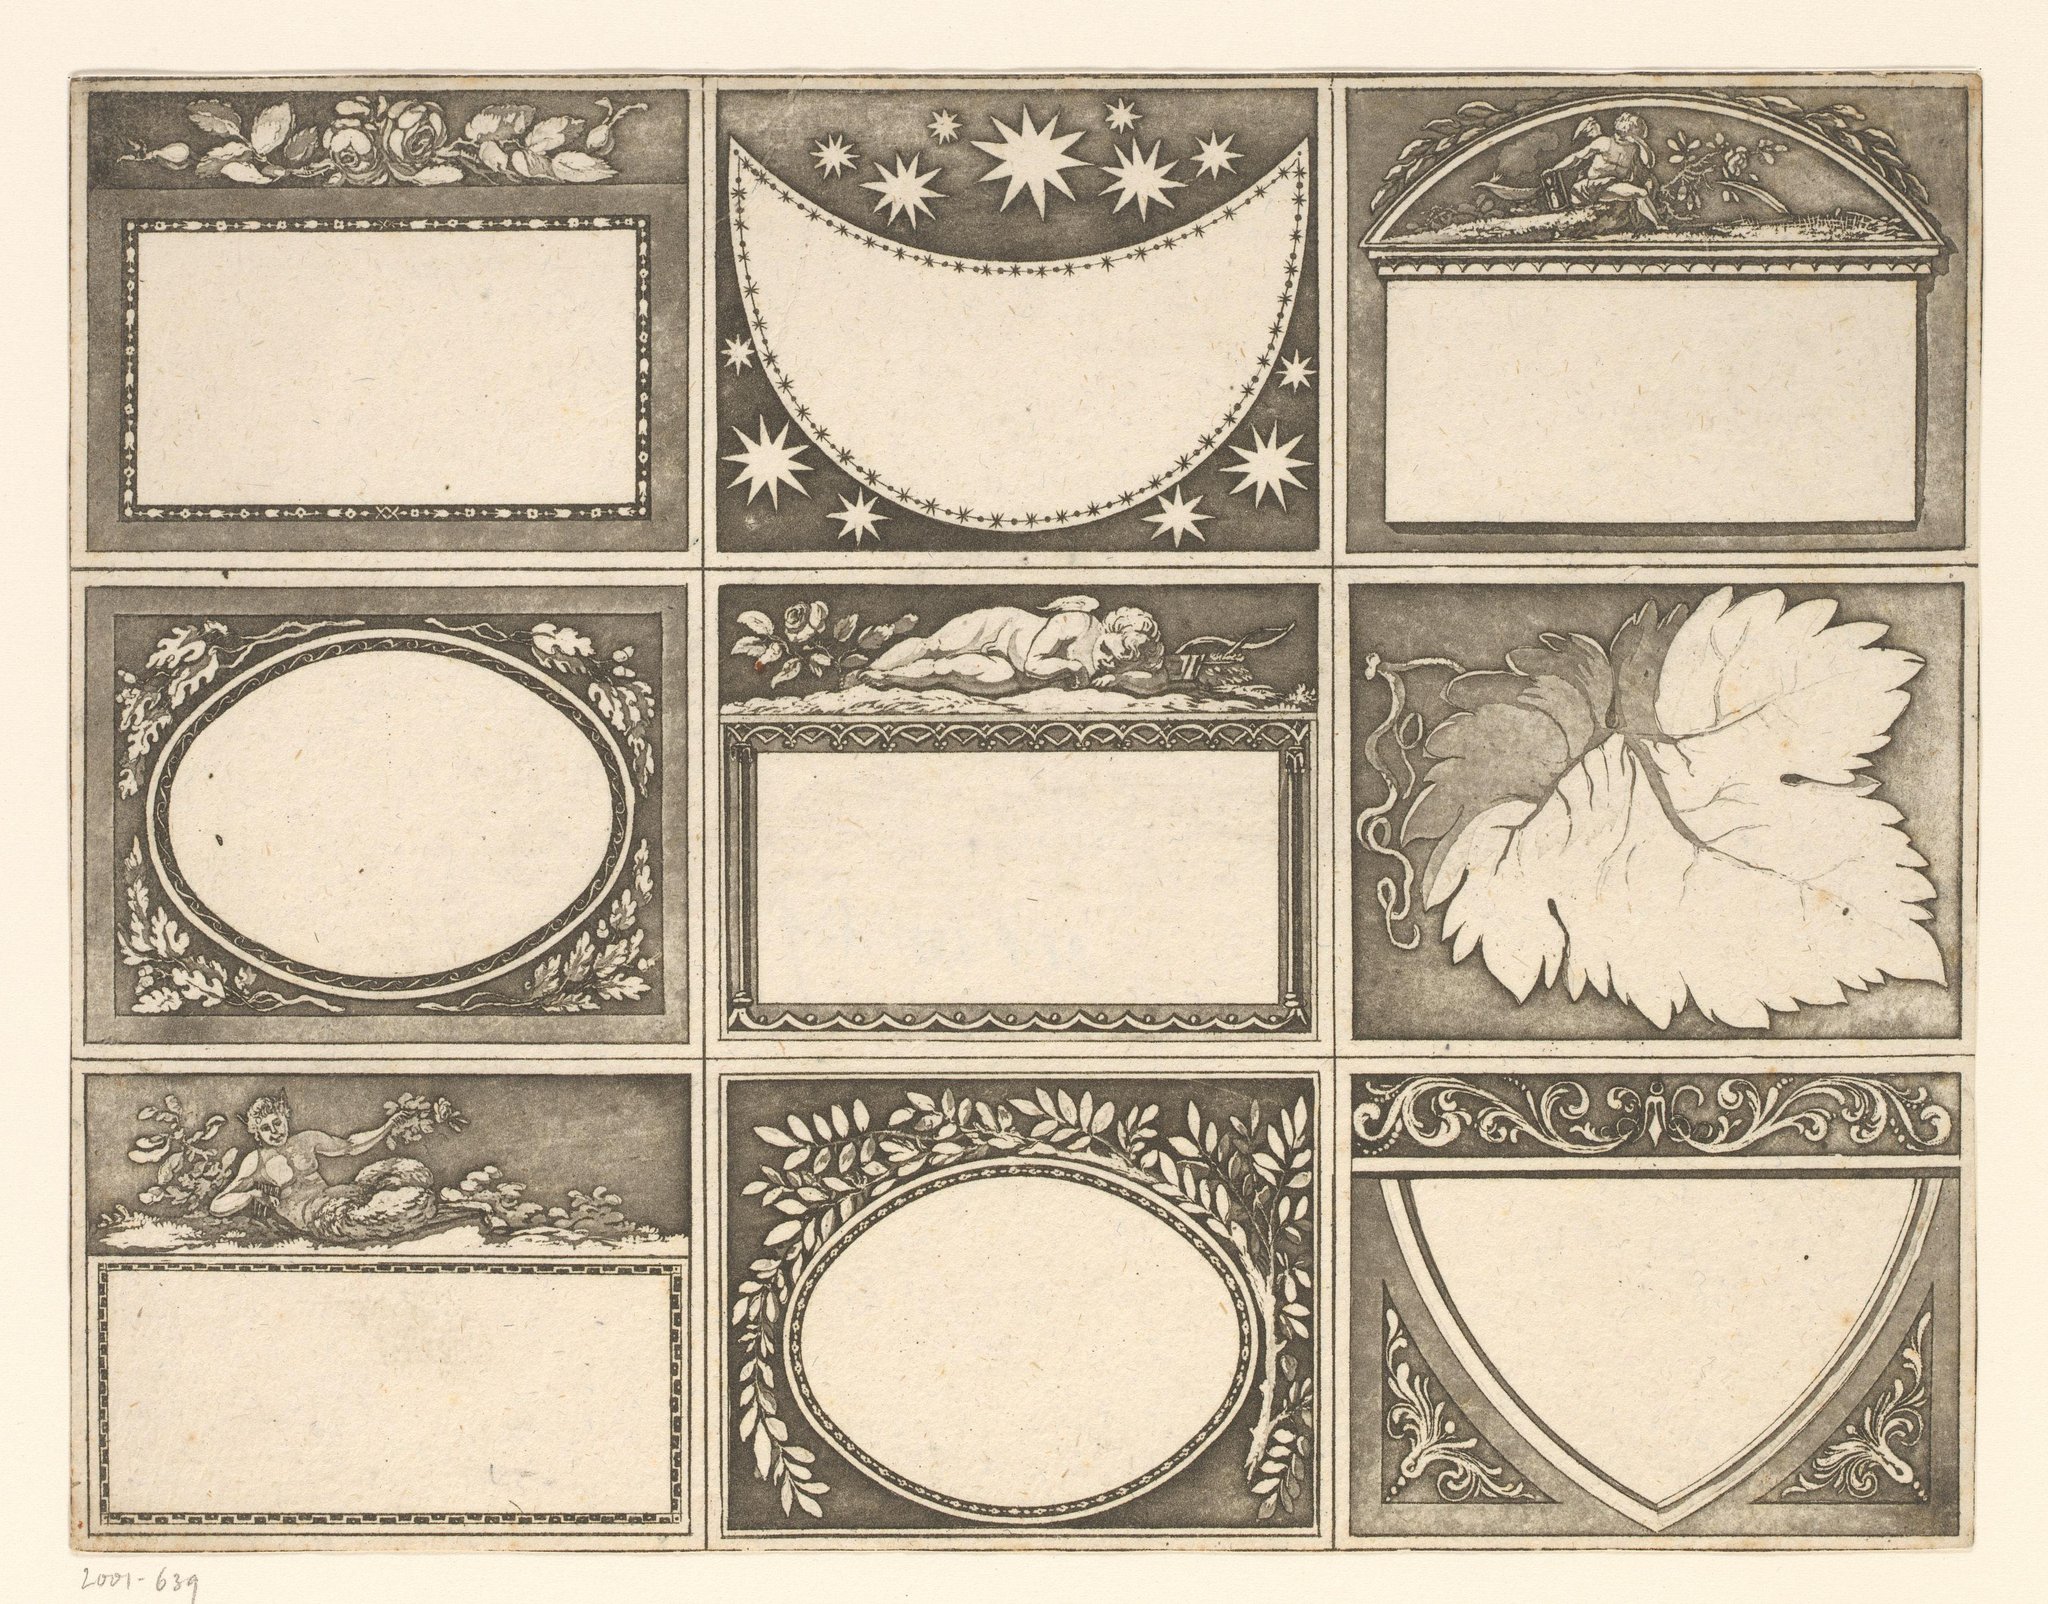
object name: visiting card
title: Negen ontwerpen voor visitekaartjes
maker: Anonymous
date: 1700-1799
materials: paper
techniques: aquatint, etching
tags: vine-tendril, leaf, satyr(s) (in general), ornament ~ cartouche, flowers: rose, cupids: 'amores', 'amoretti', 'putti'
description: Cartouches in verschillende vormen (waaronder een met erboven een liggende sater, een ander met een slapende Amor, en derde met een putto met zandloper) en een druivenblad.